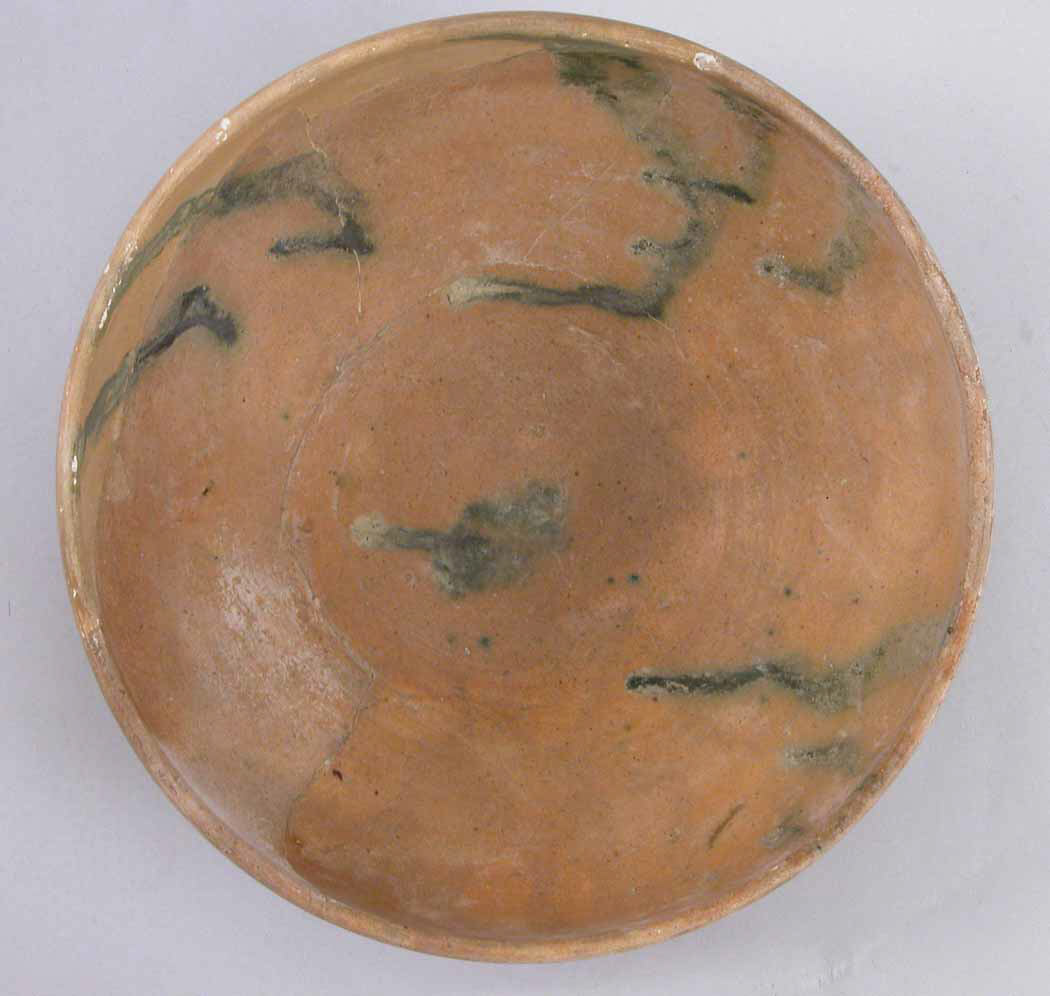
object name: bowl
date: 801-1000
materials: earthenware, glaze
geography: iran